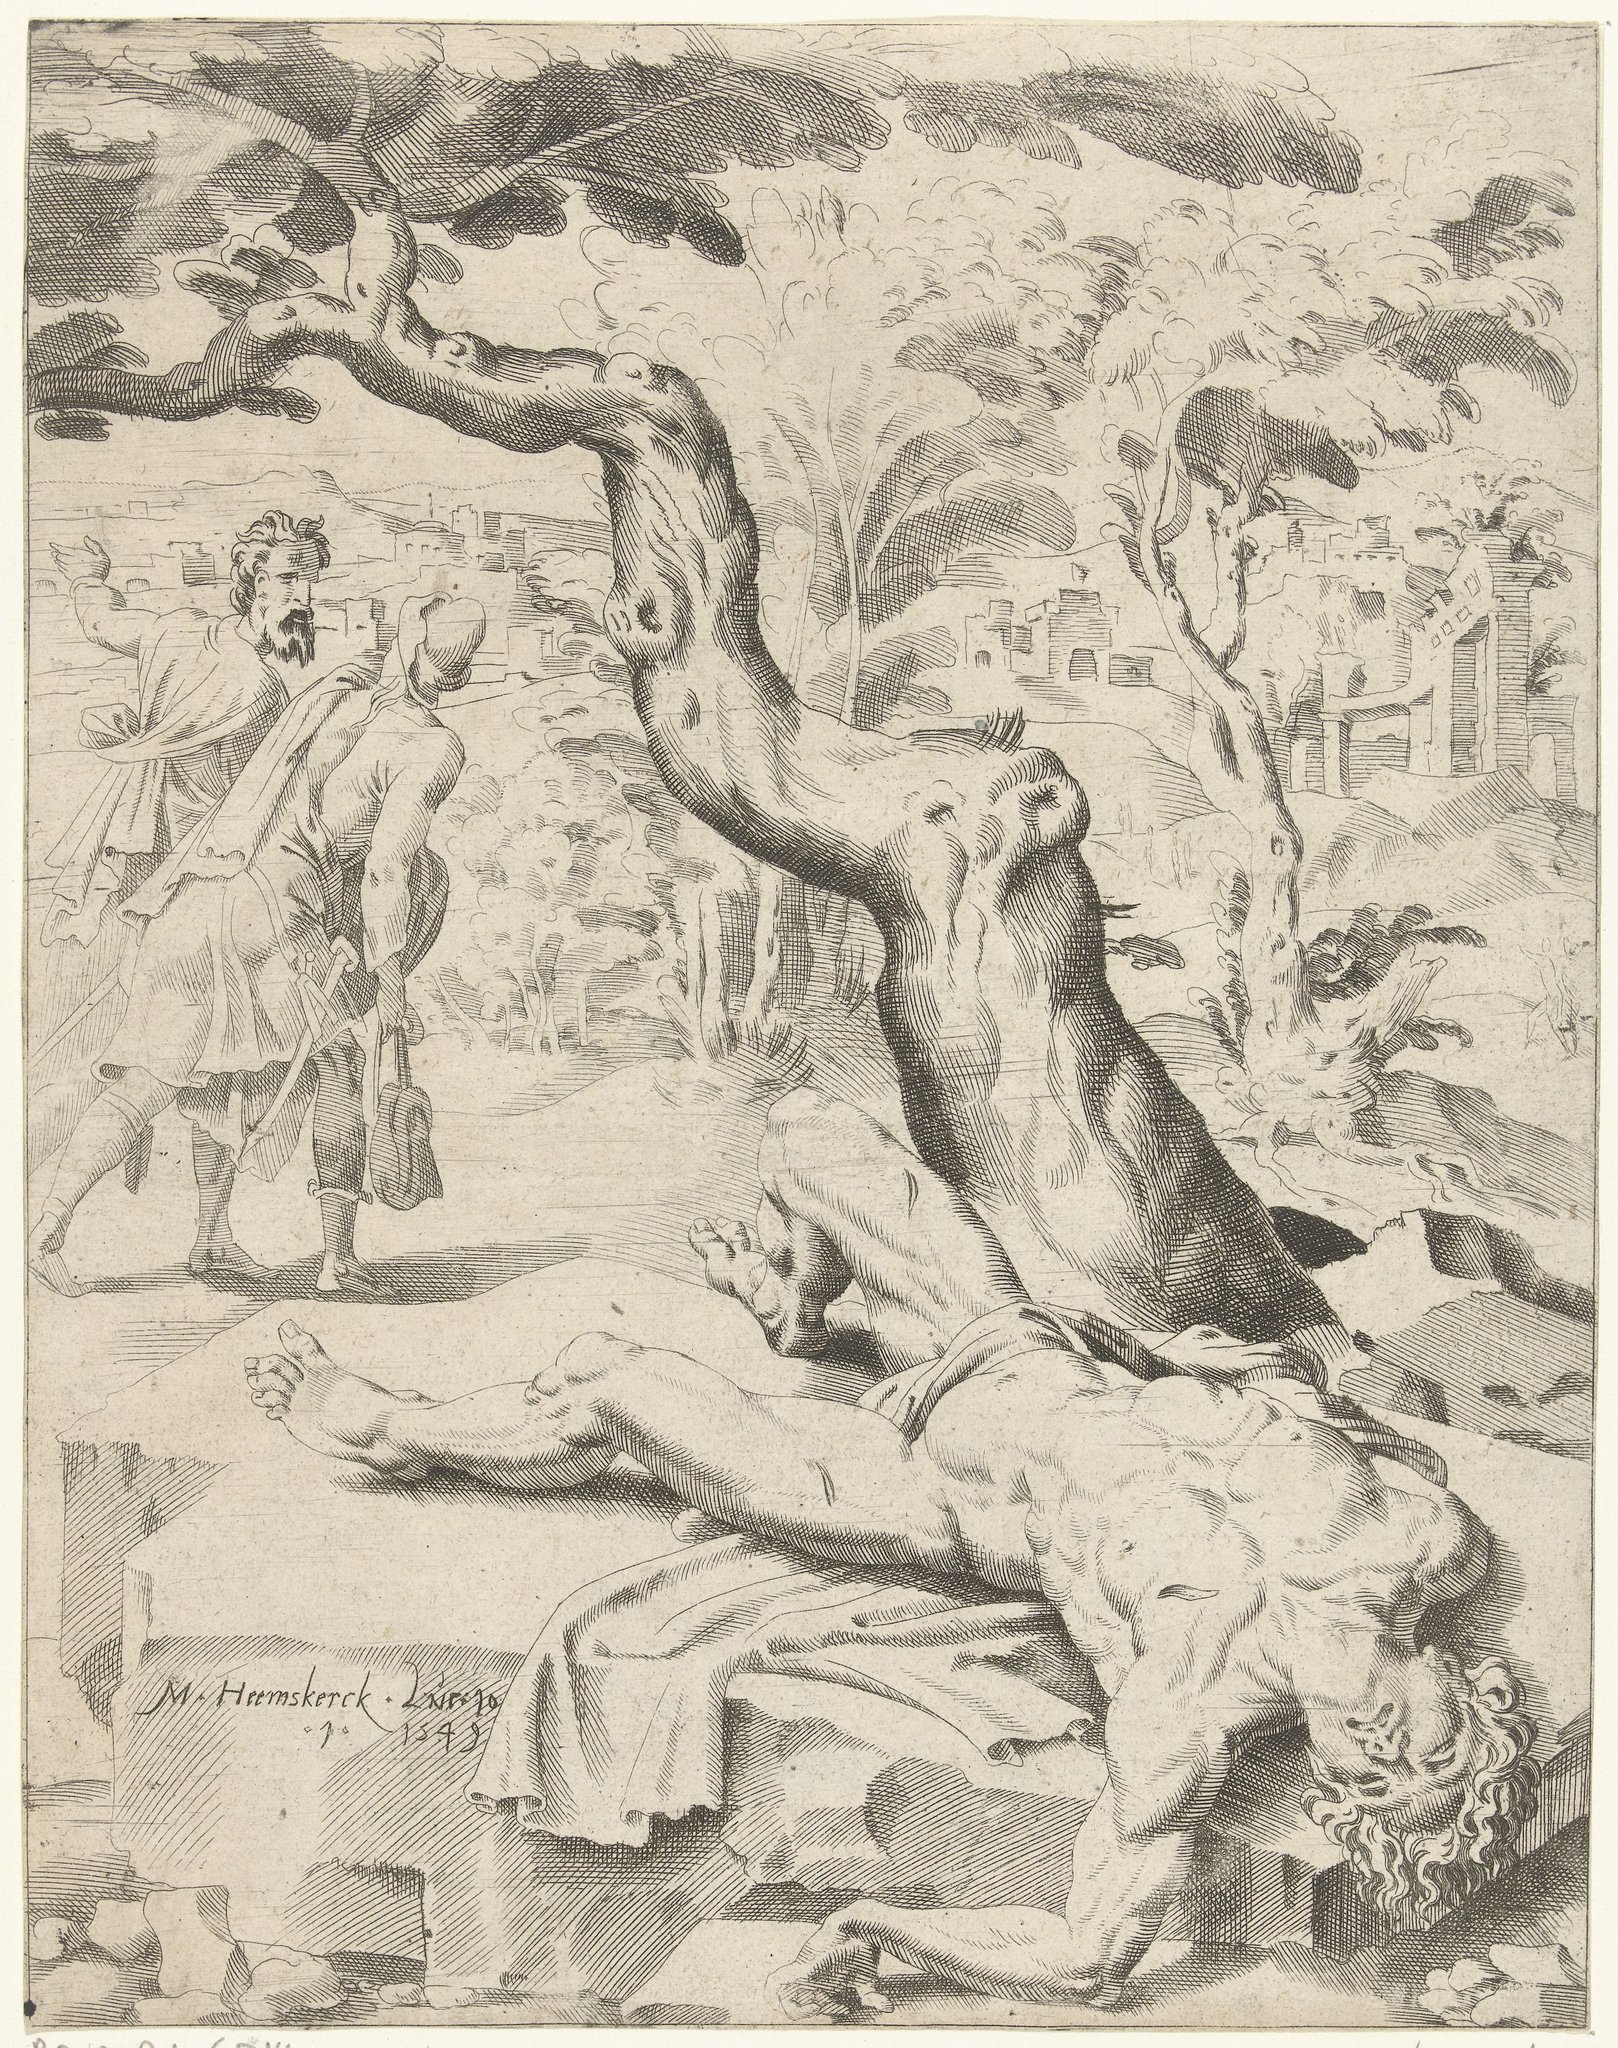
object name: print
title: Gelijkenis van de barmhartige Samaritaan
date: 1549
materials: paper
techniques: etching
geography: haarlem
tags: the traveller is attacked by robbers ~ parable of the good samaritan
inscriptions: collector's mark: Lugt 2228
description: Twee mannen hebben een reizer overvallen, zijn kleren uitgetrokken en laten hem voor halfdood liggen. De prent maakt deel uit van een serie over Gelijkenis van de barmhartige Samaritaan.